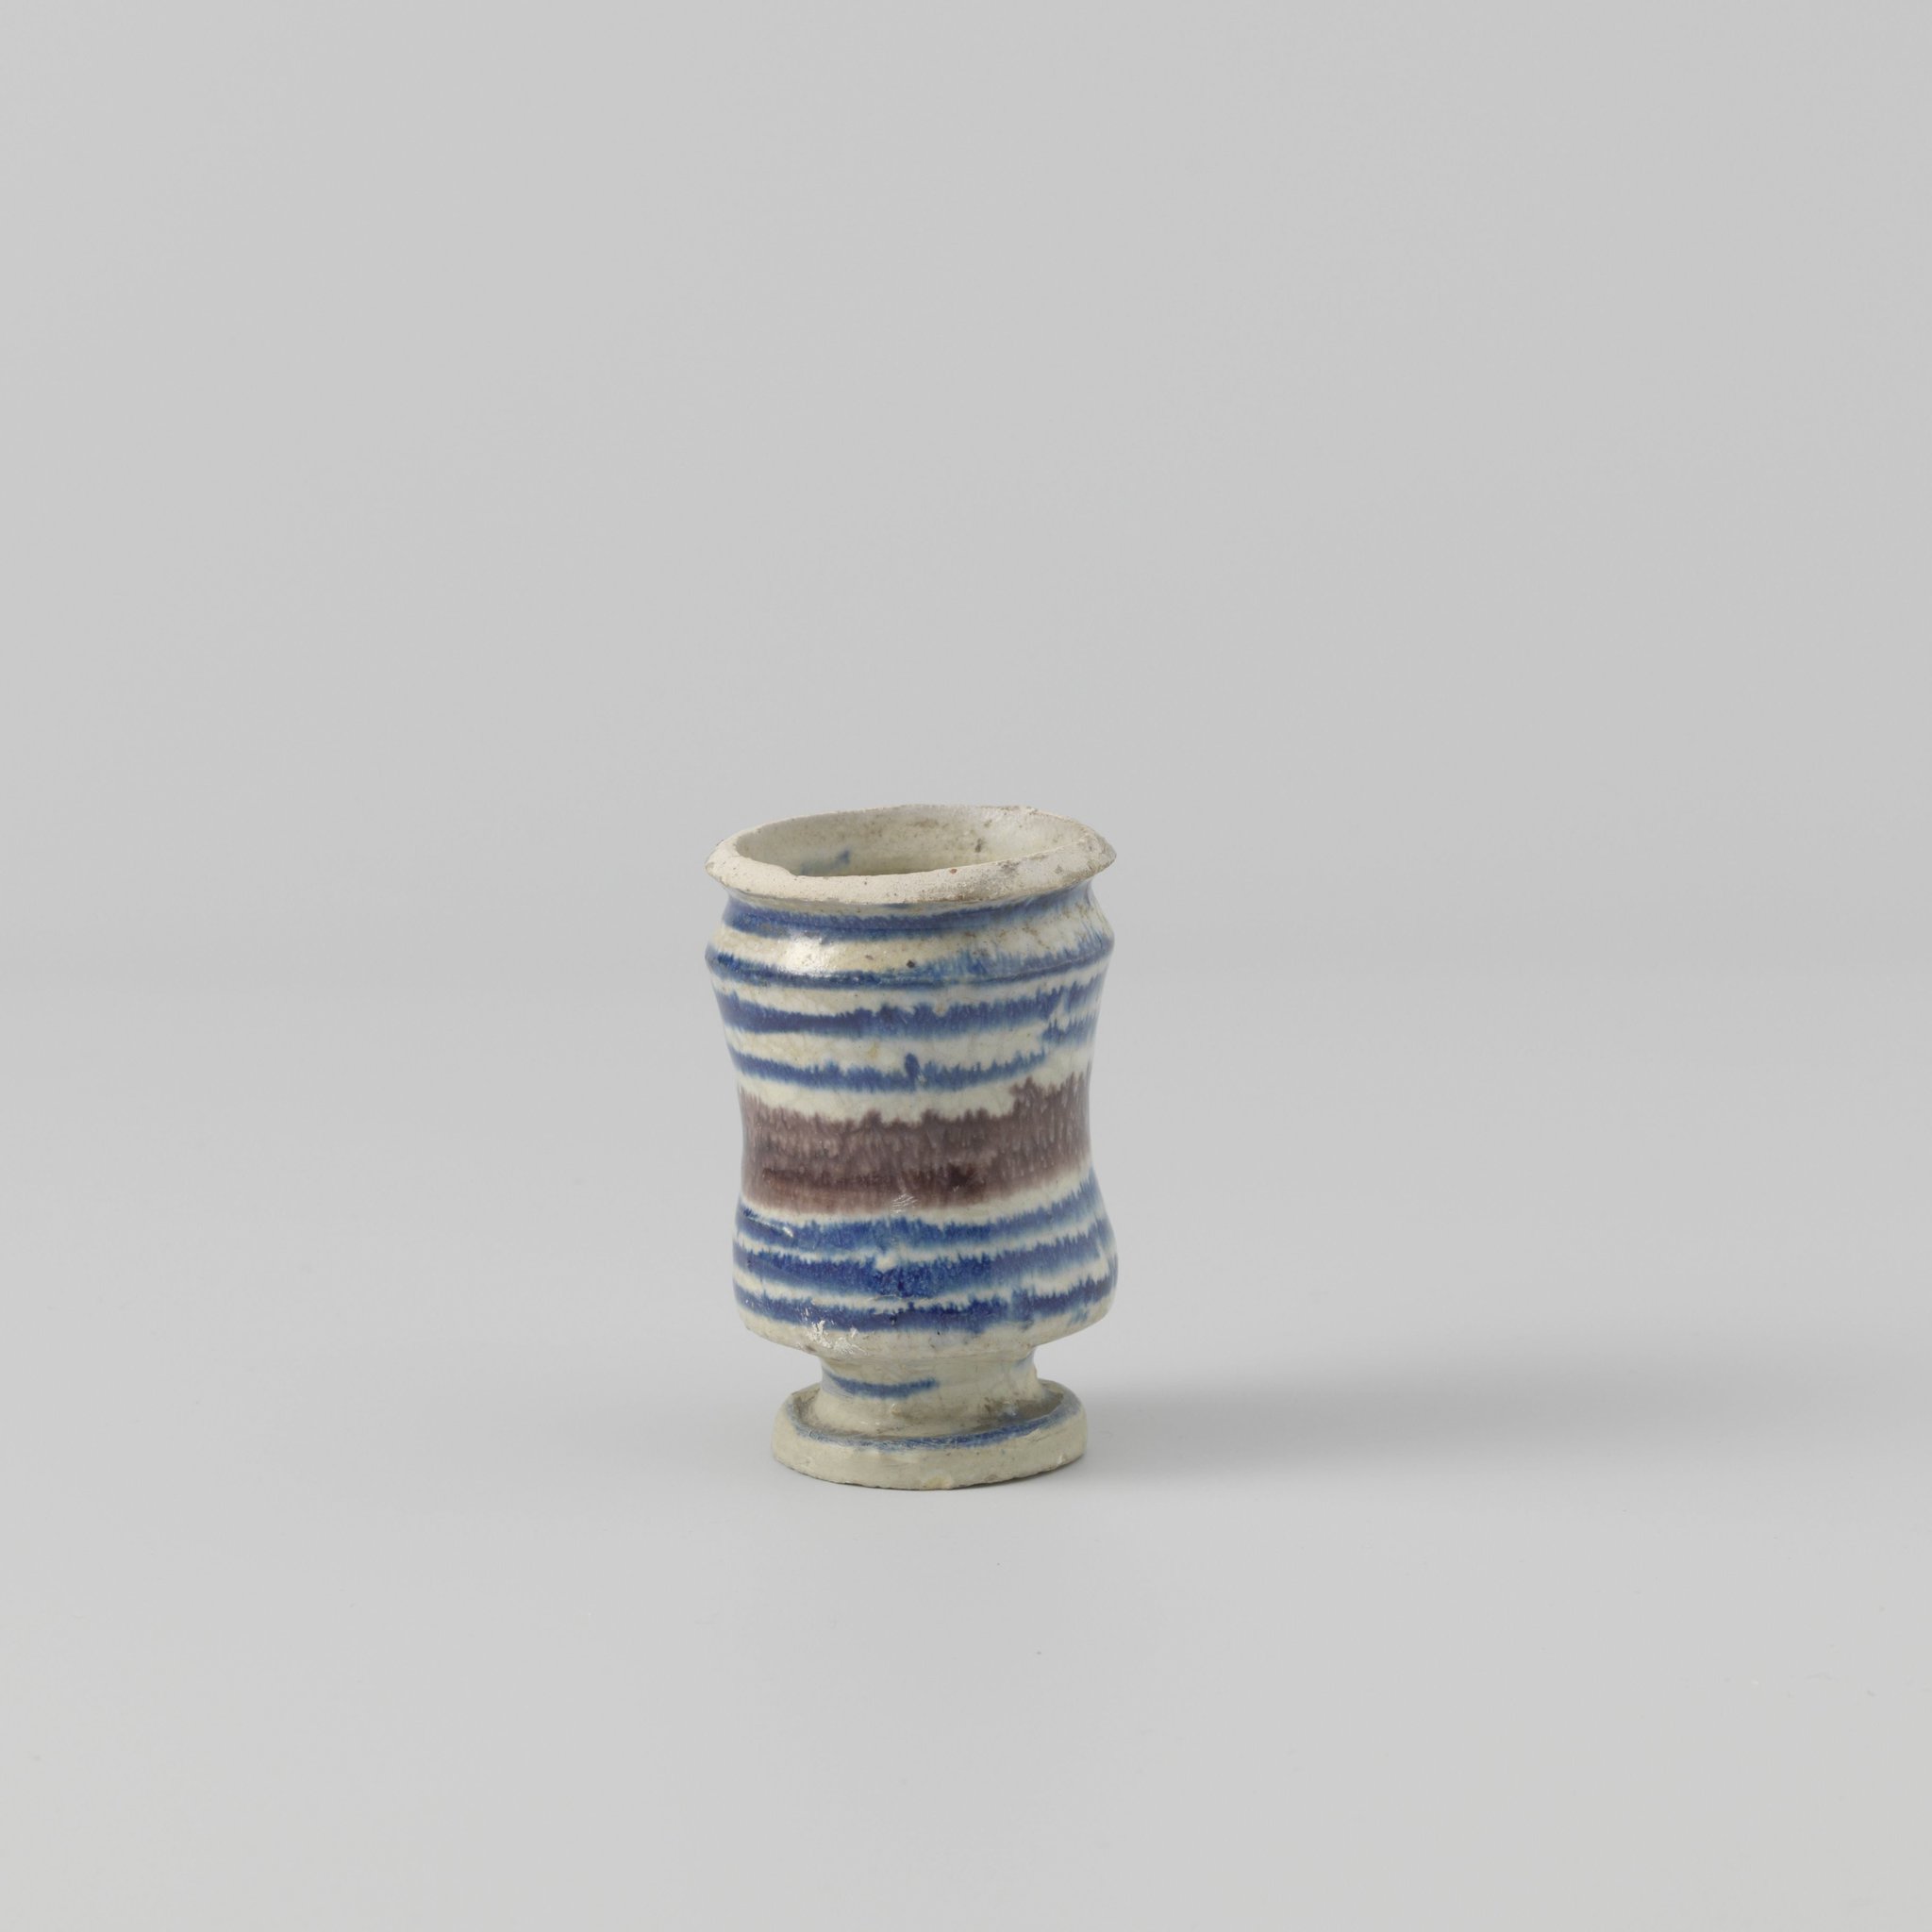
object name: apothecary jar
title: Apothekerspot, veelkleurig beschilderd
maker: Anonymous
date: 1560-1625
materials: earthenware, glaze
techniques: maiolica, painted, polychromy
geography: netherlands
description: Concaaf cilindrische pot van veelkleurig beschilderde majolica, op een voet en met een ingesnoerde hals. De pot is beschilderd met blauwe horizontale lijnen en in het midden een mangaan paarse band. De kleuren lijken te zijn doorgelopen.